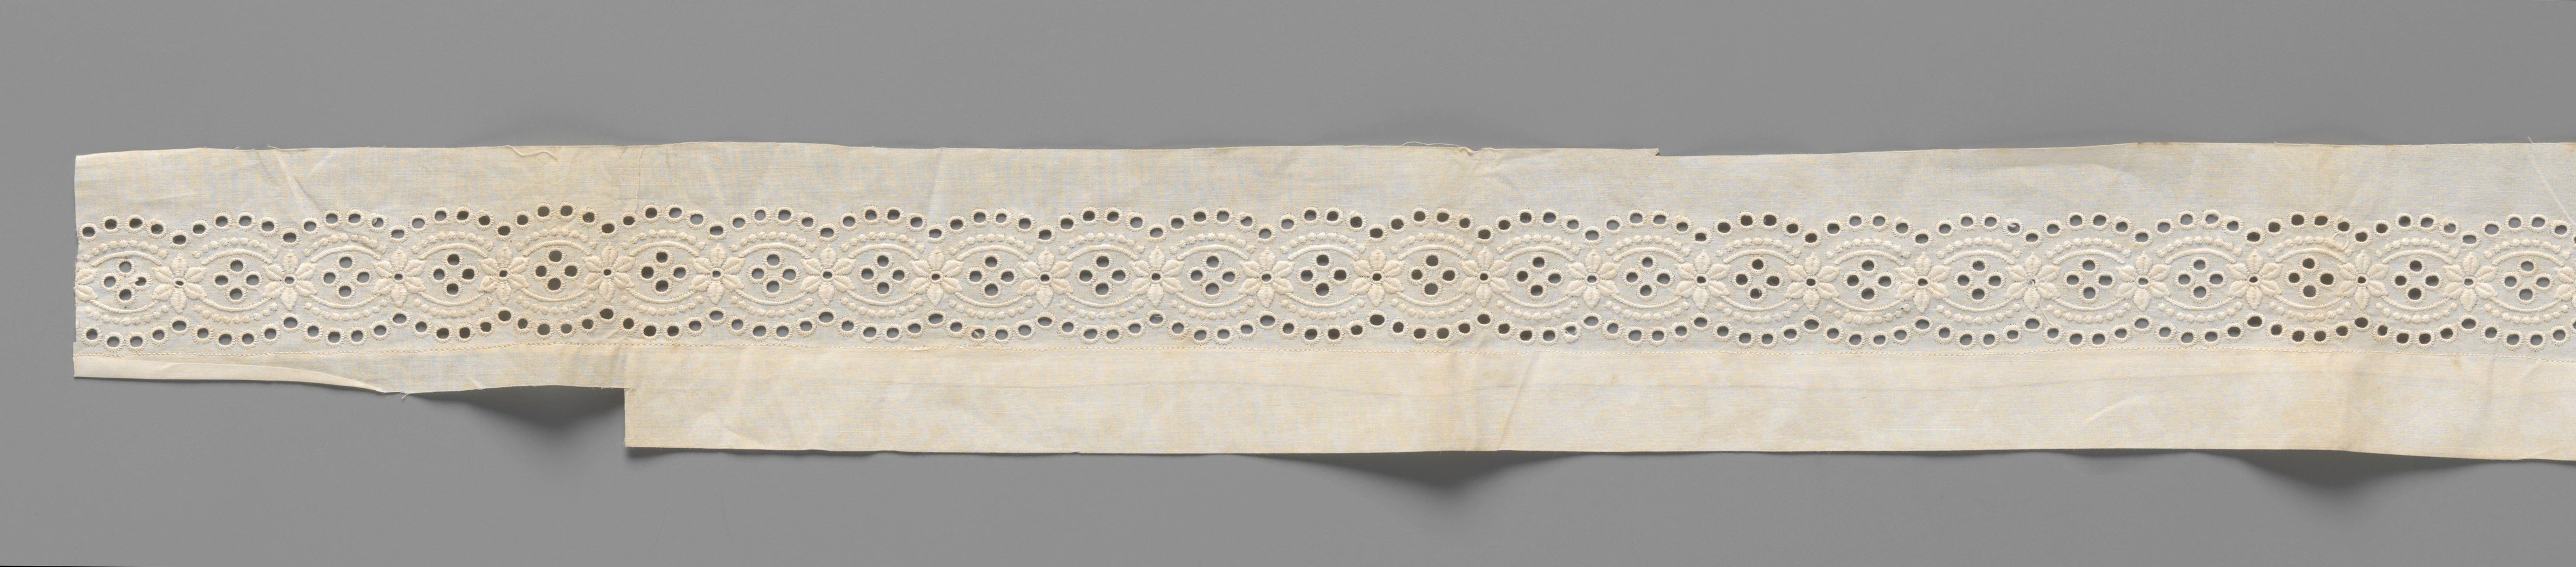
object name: strip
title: Strook katoen met machinale kant met aaneengeschakelde ovalen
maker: Anonymous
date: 1890-1899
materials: linen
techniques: lace, weave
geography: europe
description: Strook katoen met naturelkleurige machinale kant: machinaal Engels borduurwerk. Het patroon bestaat uit één rij aaneengeschakelde ovalen. Op de kruispunten staat steeds een stervormige bloem. In de ovalen staan vier opengewerkte cirkels. Boven en onder de ovalen loopt een doorgaande 'parellijst' van opengewerkte cirkeltjes. De lijst volgt de contouren van de ovalen.